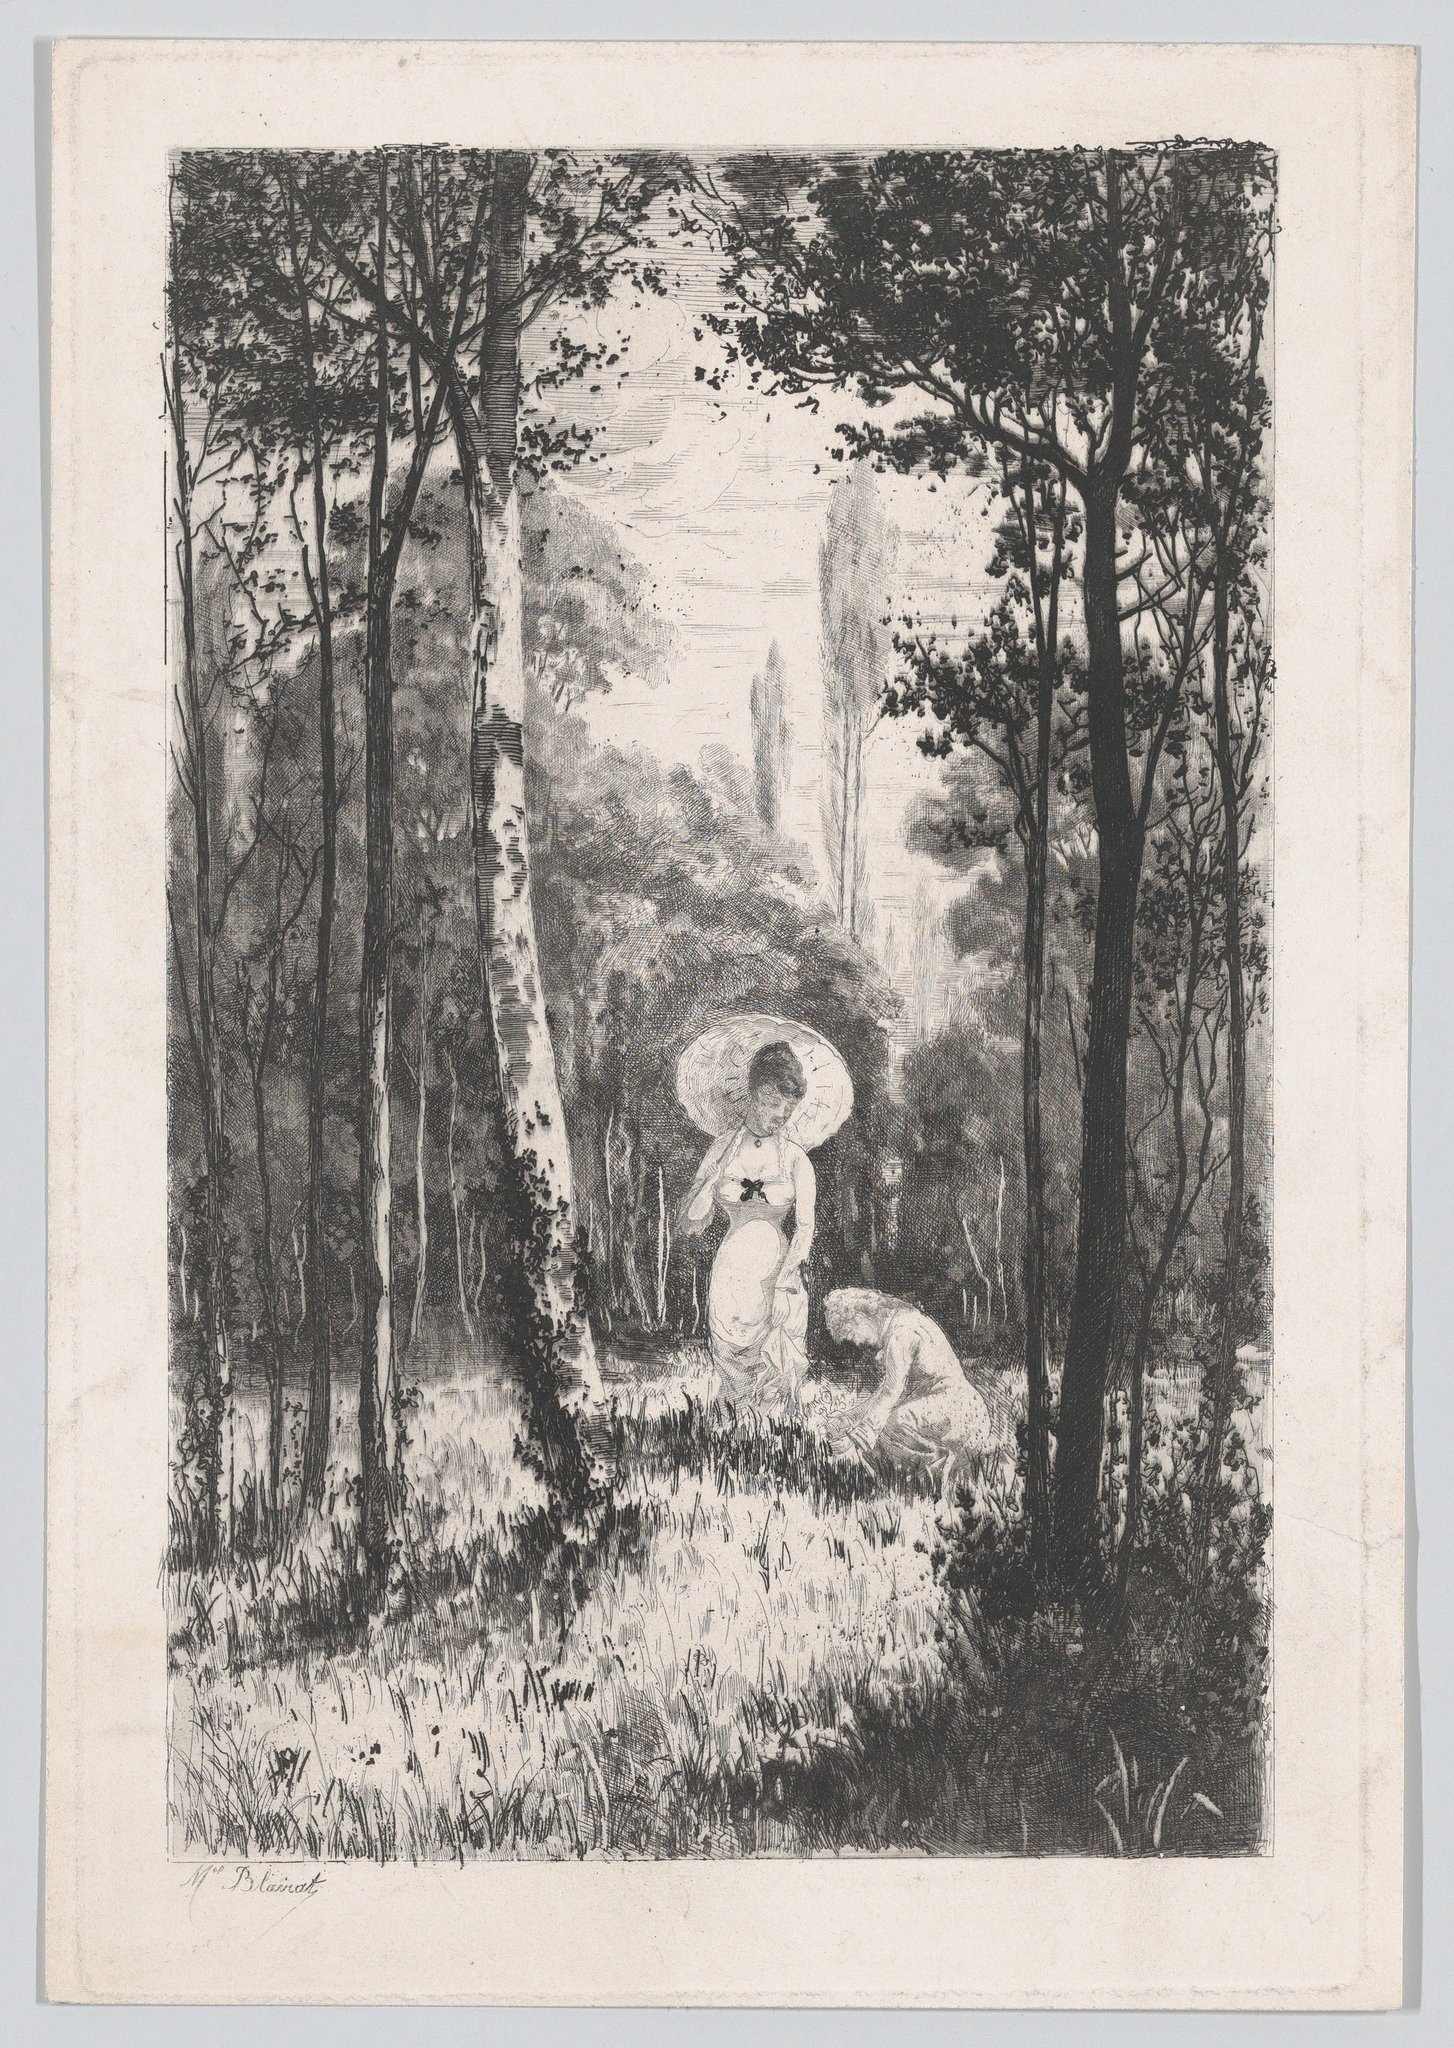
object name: print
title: Two women in a clearing in the woods, one holding a parasol, the other seated in the grass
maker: marcel blairat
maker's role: artist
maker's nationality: french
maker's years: 1849-1891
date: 1870-1891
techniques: etching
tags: women,forests